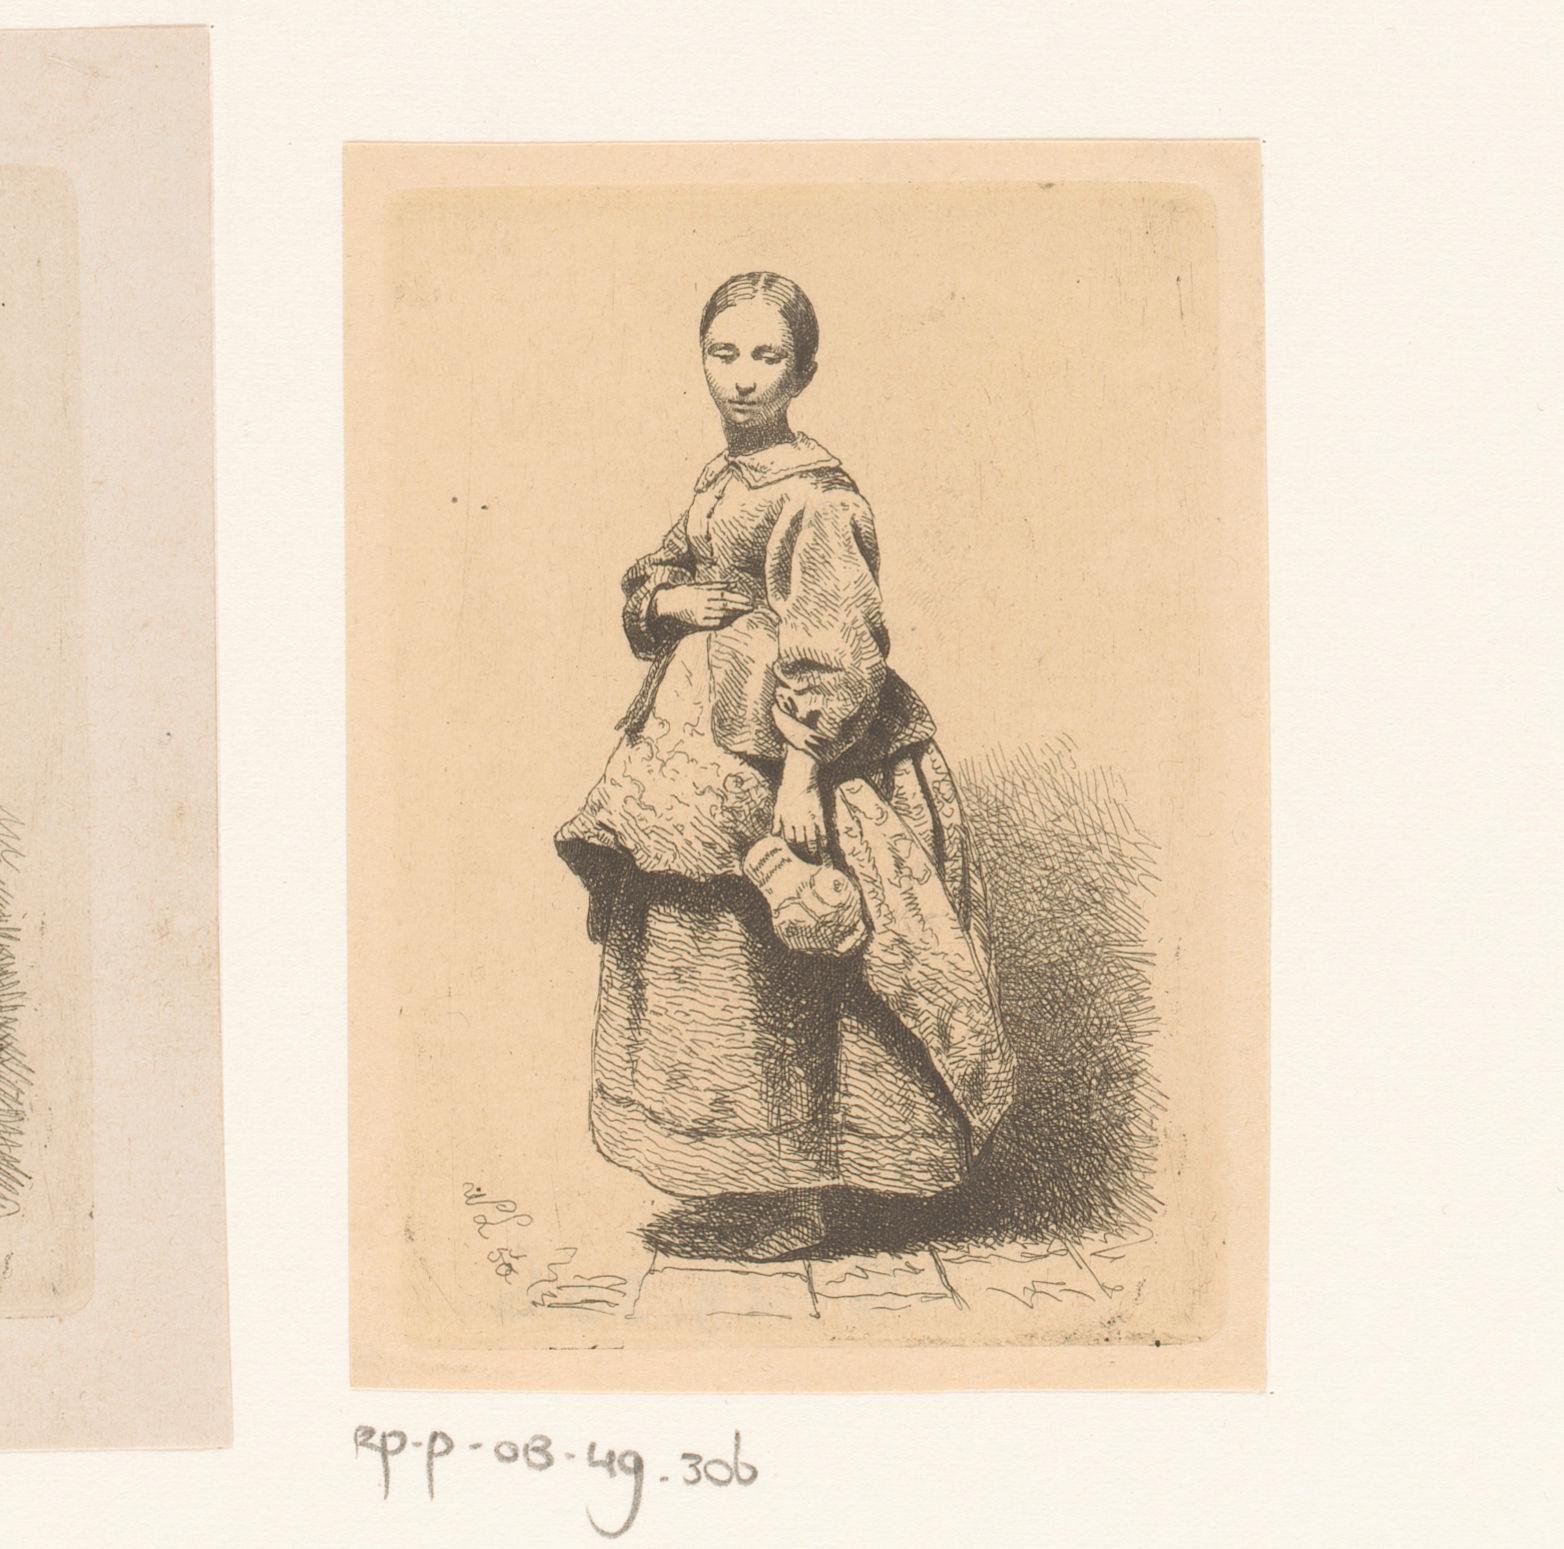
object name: print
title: Staande vrouw met een kruik in de hand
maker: willem linnig (i)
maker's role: print maker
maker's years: 1819-1885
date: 1850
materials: paper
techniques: etching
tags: adult woman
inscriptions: collector's mark: Lugt 2228